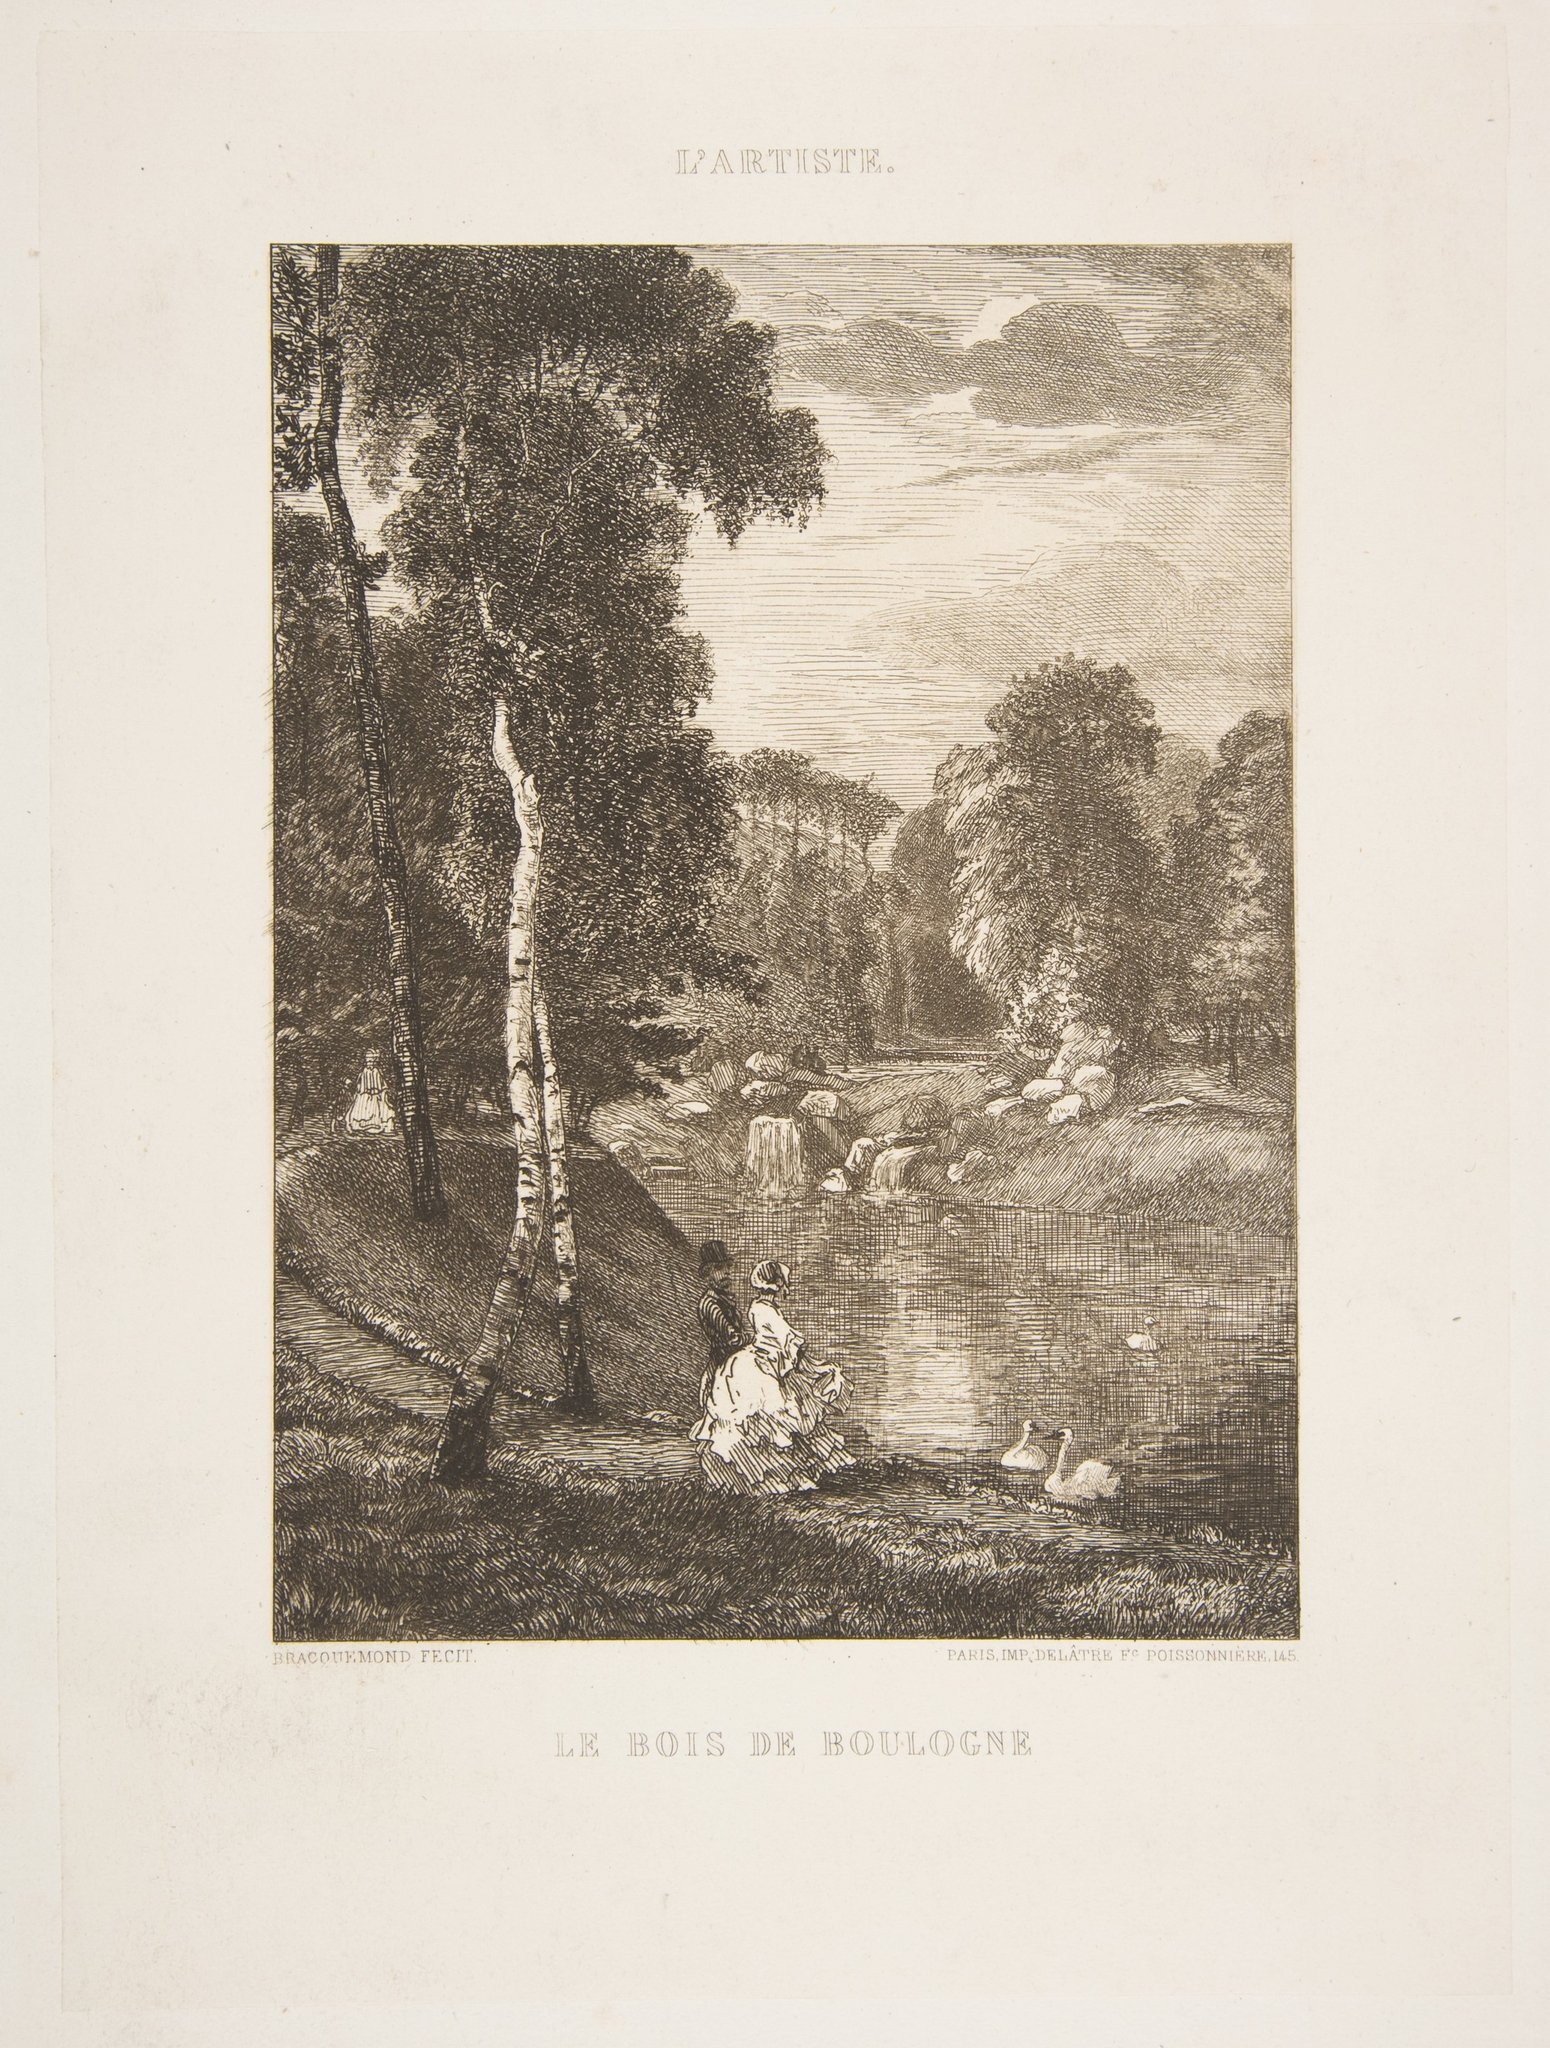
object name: print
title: Le Bois de Boulogne, from "L'Artiste"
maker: félix bracquemond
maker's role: artist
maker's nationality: french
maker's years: 1833-1914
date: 1857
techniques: etching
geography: france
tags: men,women,landscapes